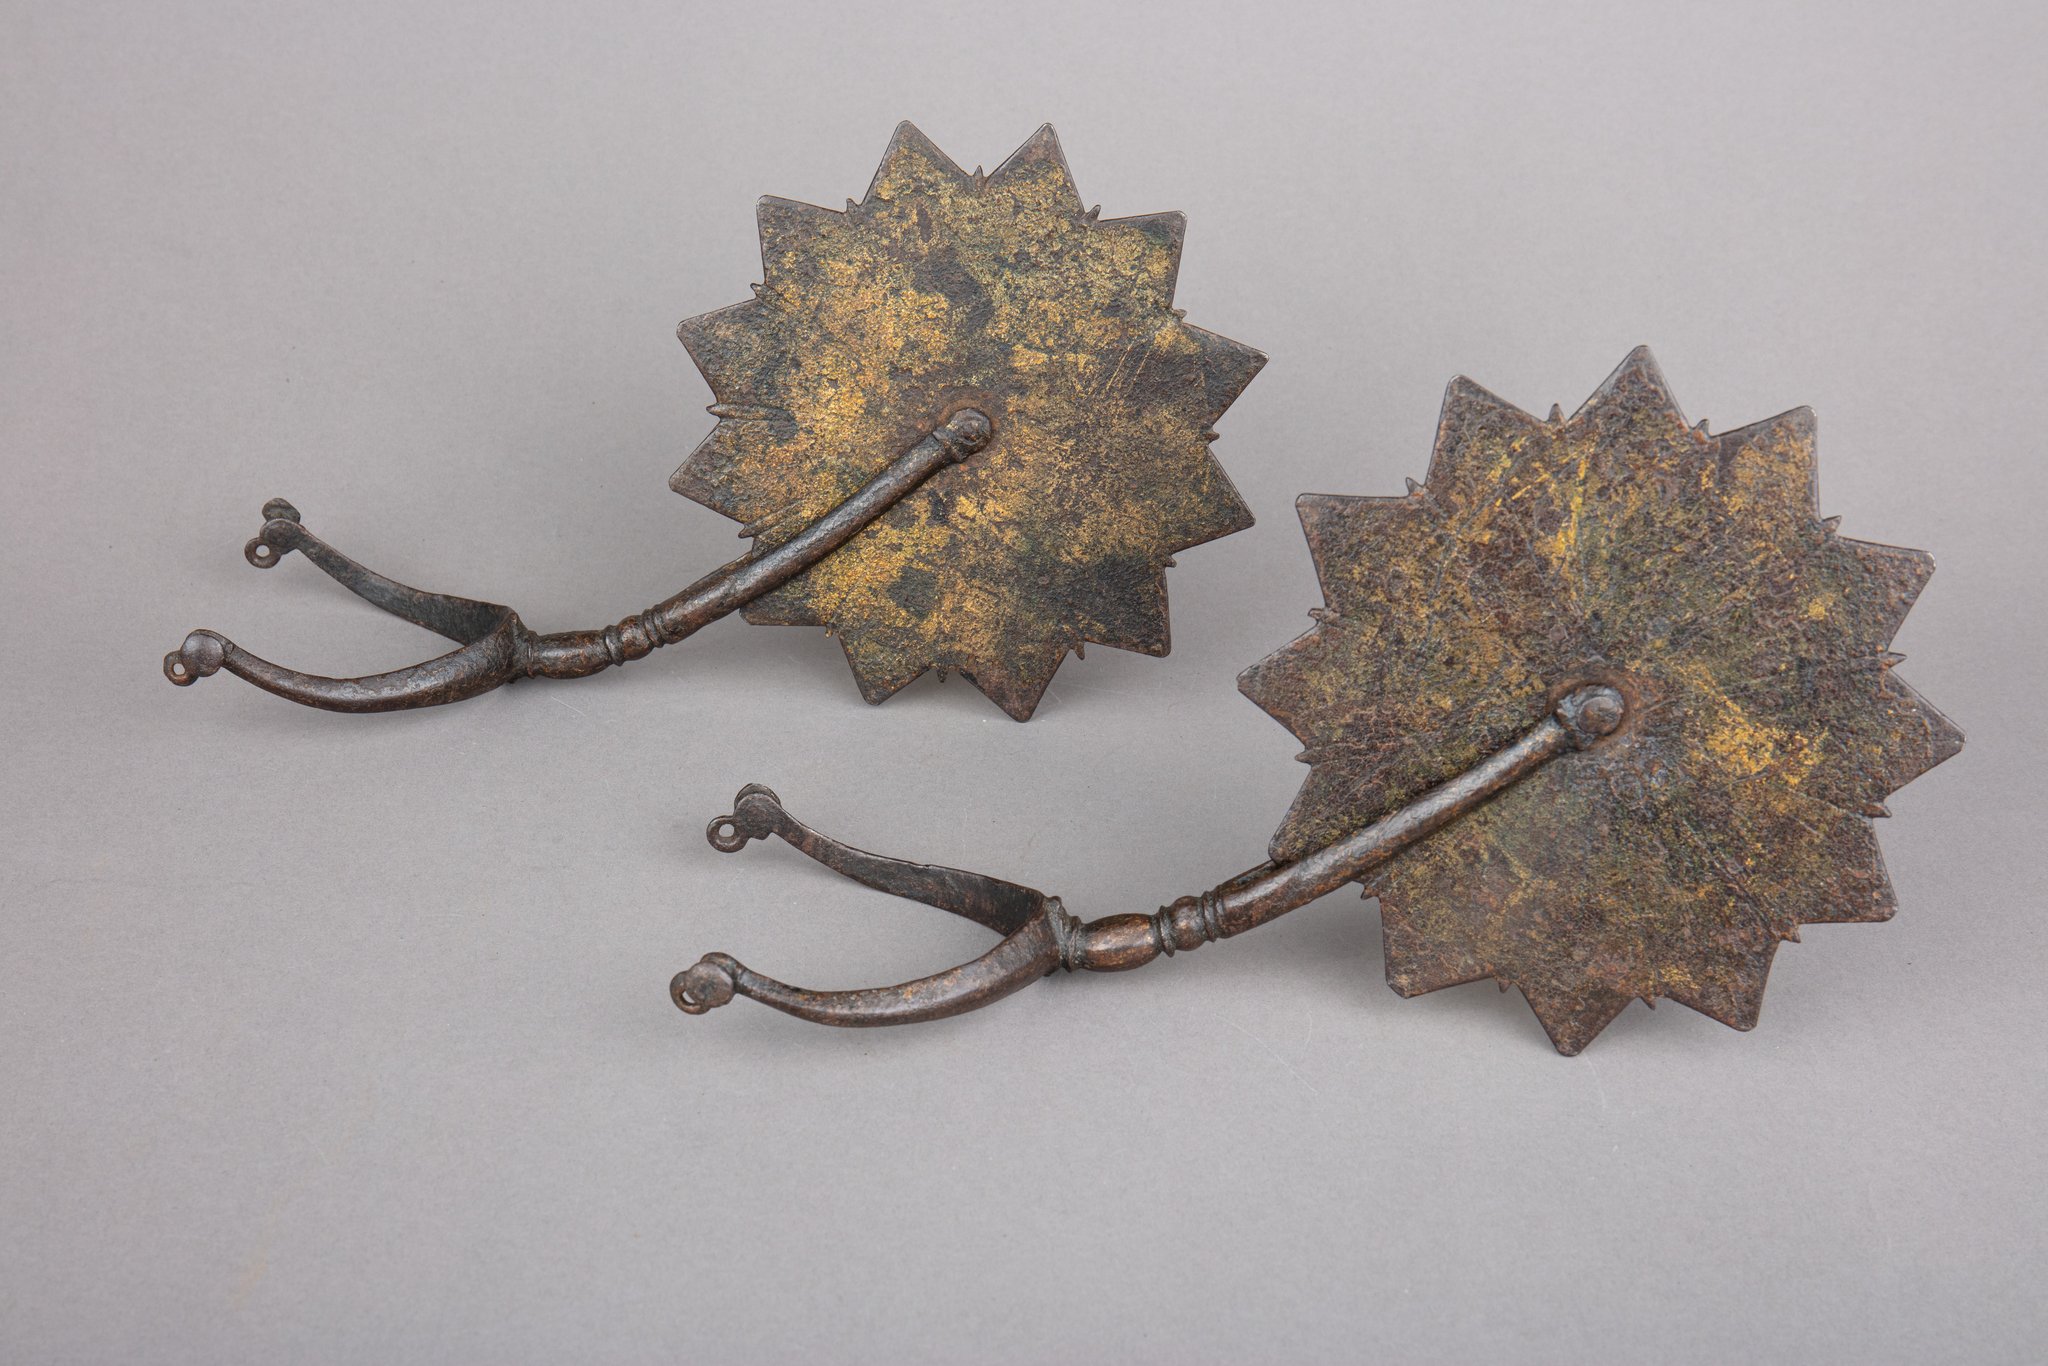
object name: spur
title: Pair of Stage Rowel Spurs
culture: french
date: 1601-1650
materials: gold, iron